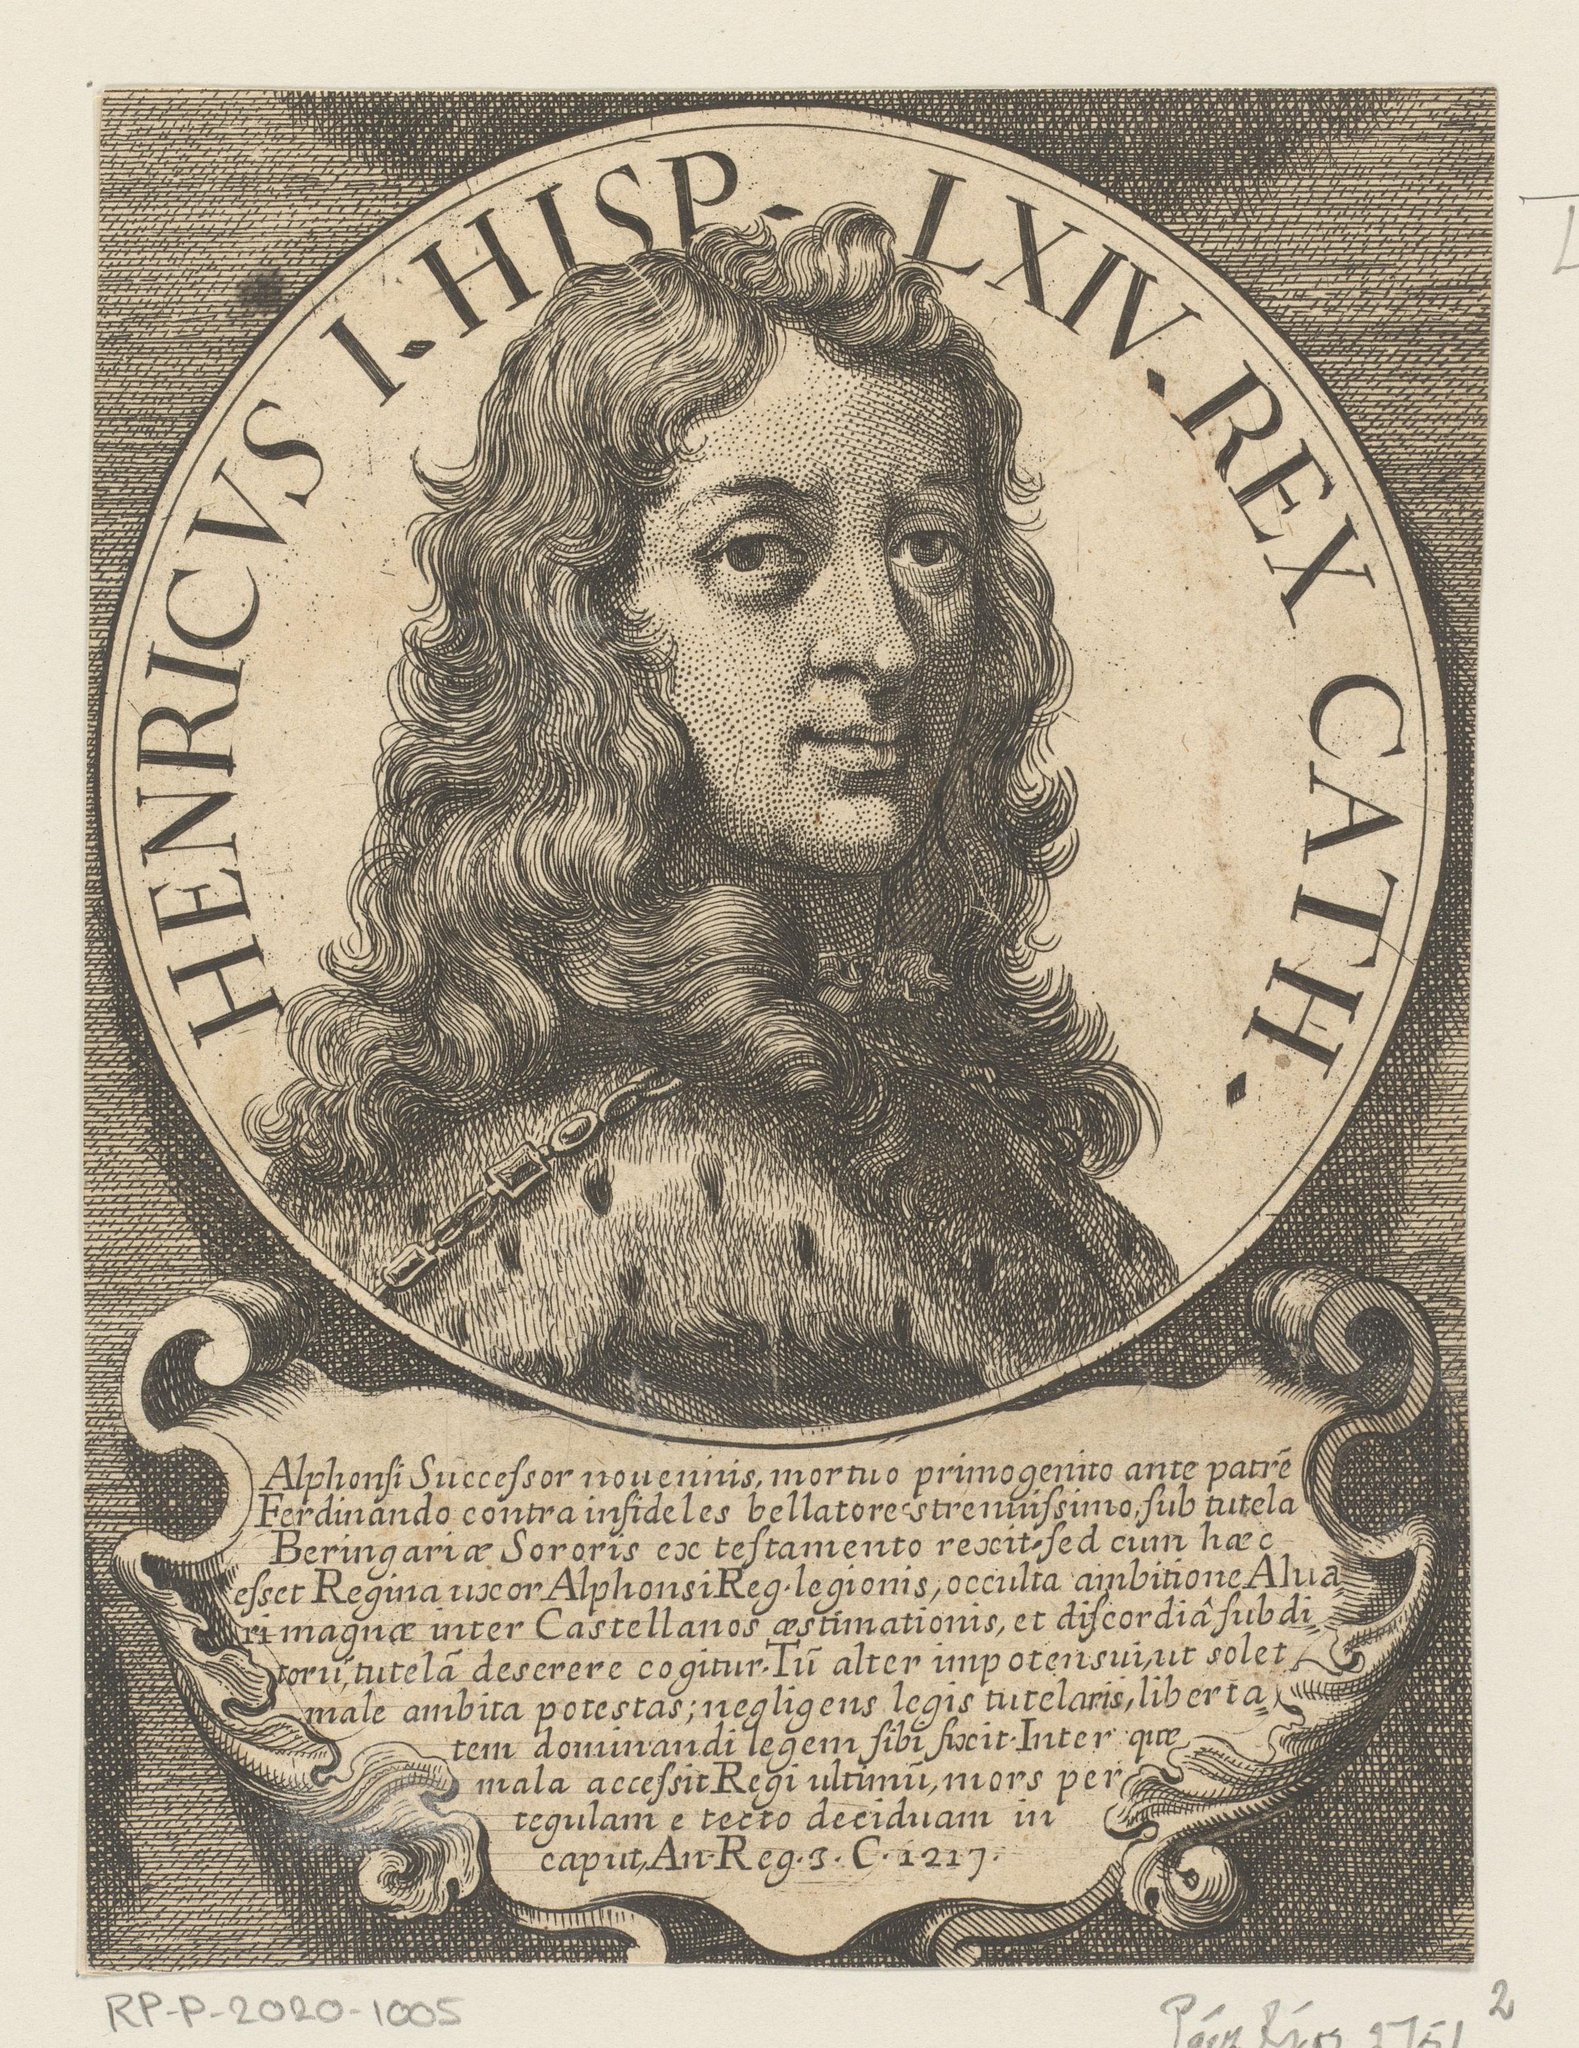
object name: print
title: Alphonsus IX Hisp LXIII Rex Ca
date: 1684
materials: paper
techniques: engraving, etching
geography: rome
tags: historical persons, ruler, sovereign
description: Portret mogelijk afkomstig van een grote prent, getiteld 'Effigies et series regum Hispaniae primum ex Gothis Christianorum (...)', bestaande uit meerdere bladen die samengevoegd konden worden, uitgegeven door Giovanni Giacomo de' Rossi in 1684.